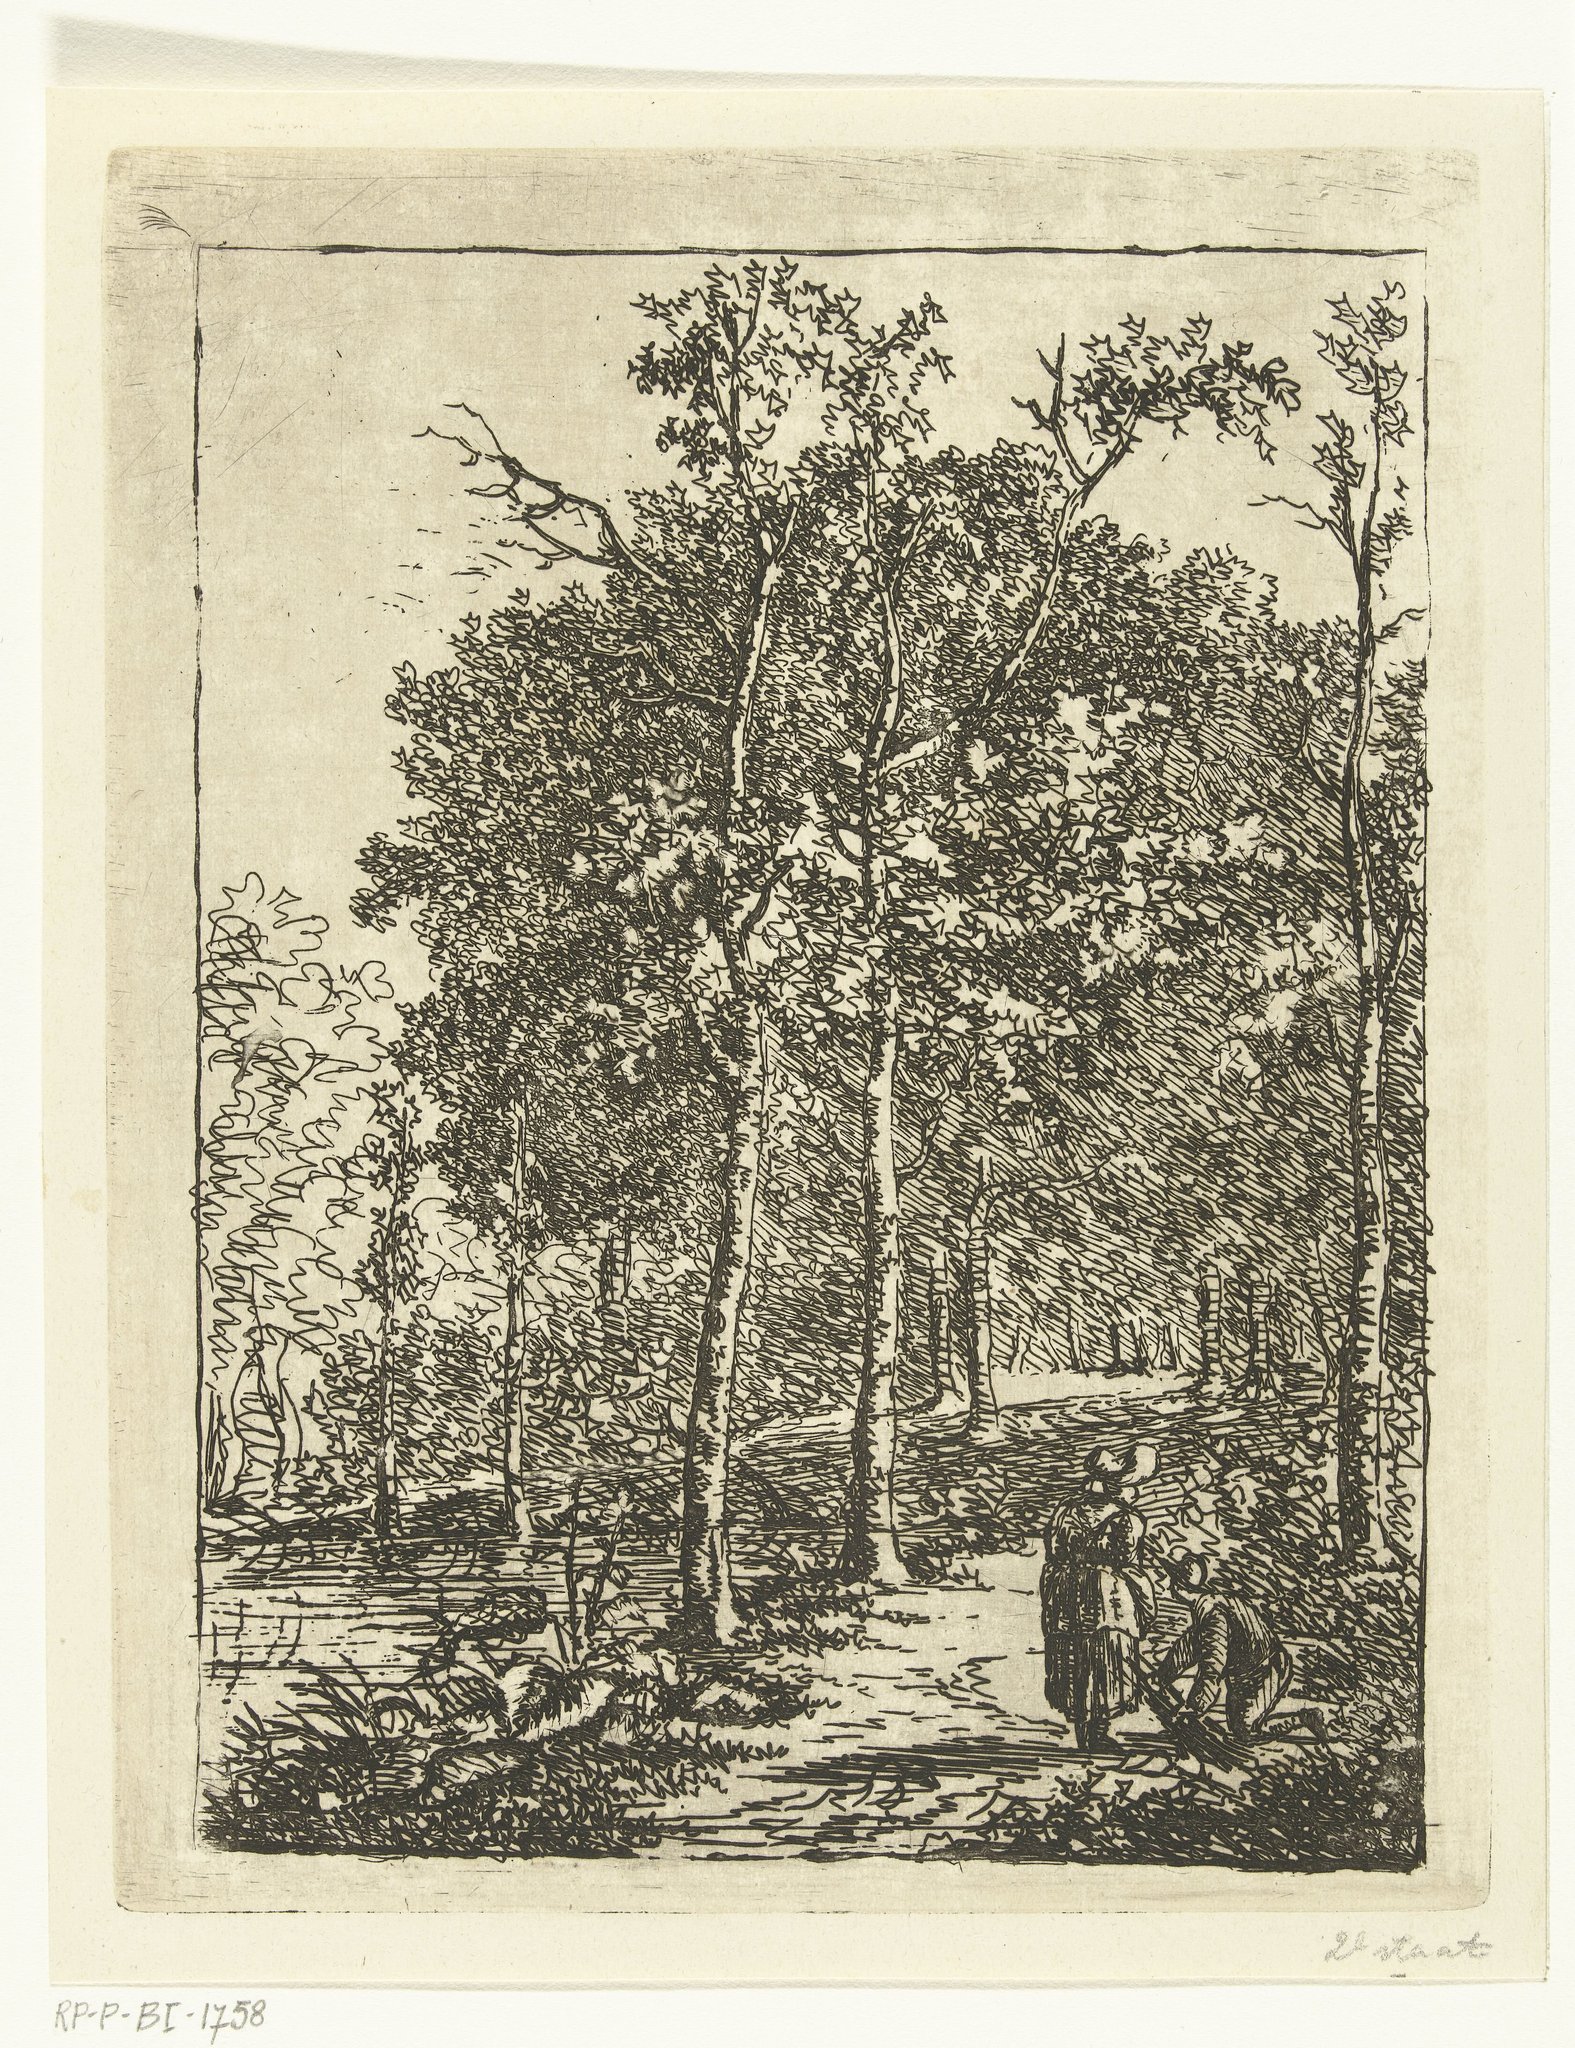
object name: print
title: Gezicht in het Haagse Bos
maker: dirk vis blokhuyzen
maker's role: print maker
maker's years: 1799-1869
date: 1809-1869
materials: paper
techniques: etching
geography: rotterdam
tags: forest, wood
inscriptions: collector's mark: Lugt 2228